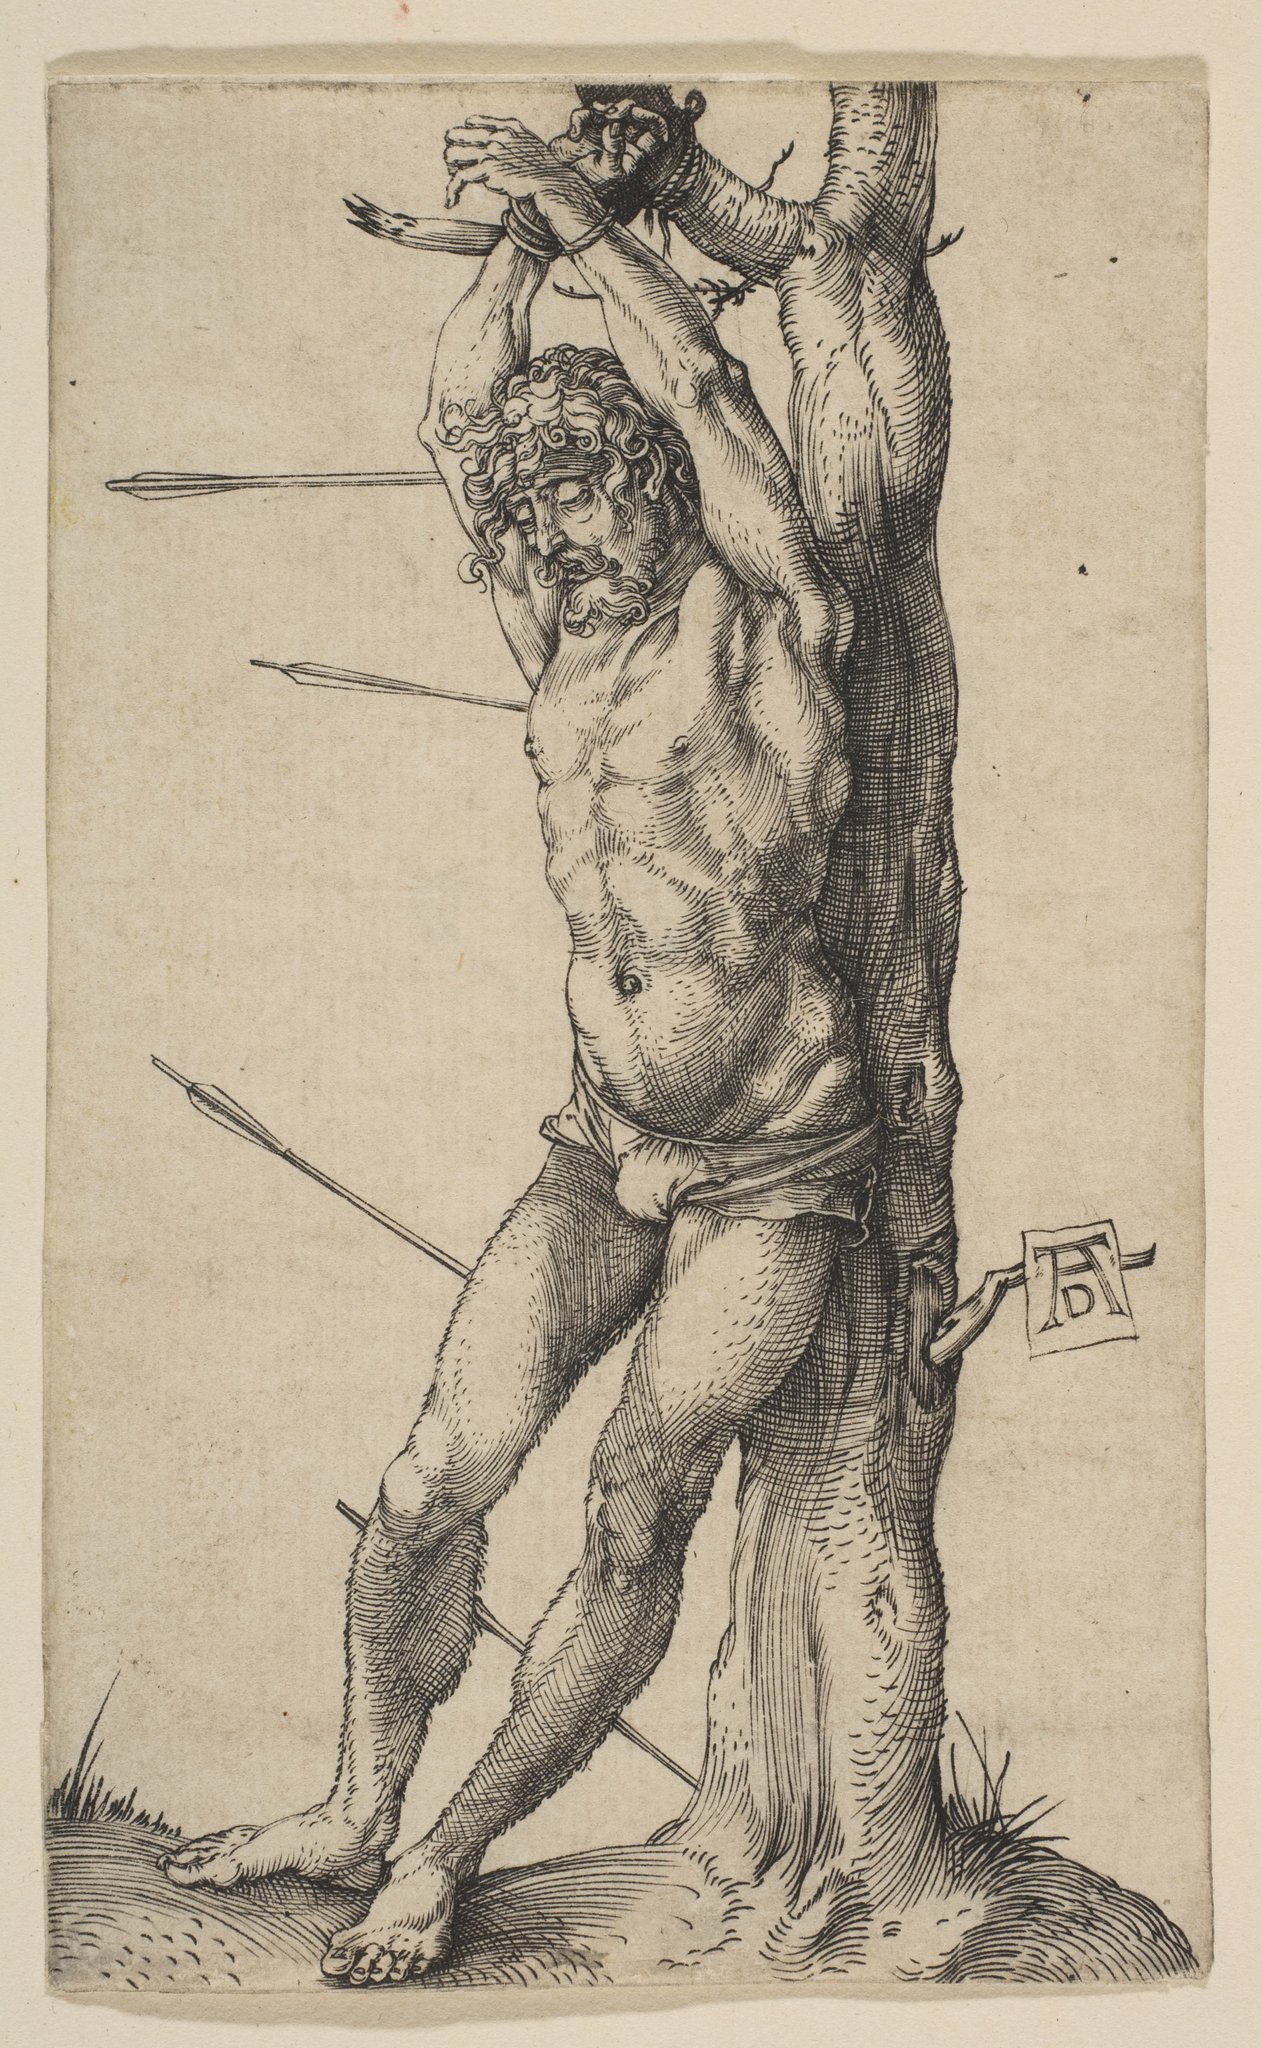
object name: print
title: Saint Sebastian Tied to a Tree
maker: albrecht dürer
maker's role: artist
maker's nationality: german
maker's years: 1471-1528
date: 1501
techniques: engraving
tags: arrows,men,trees,saints